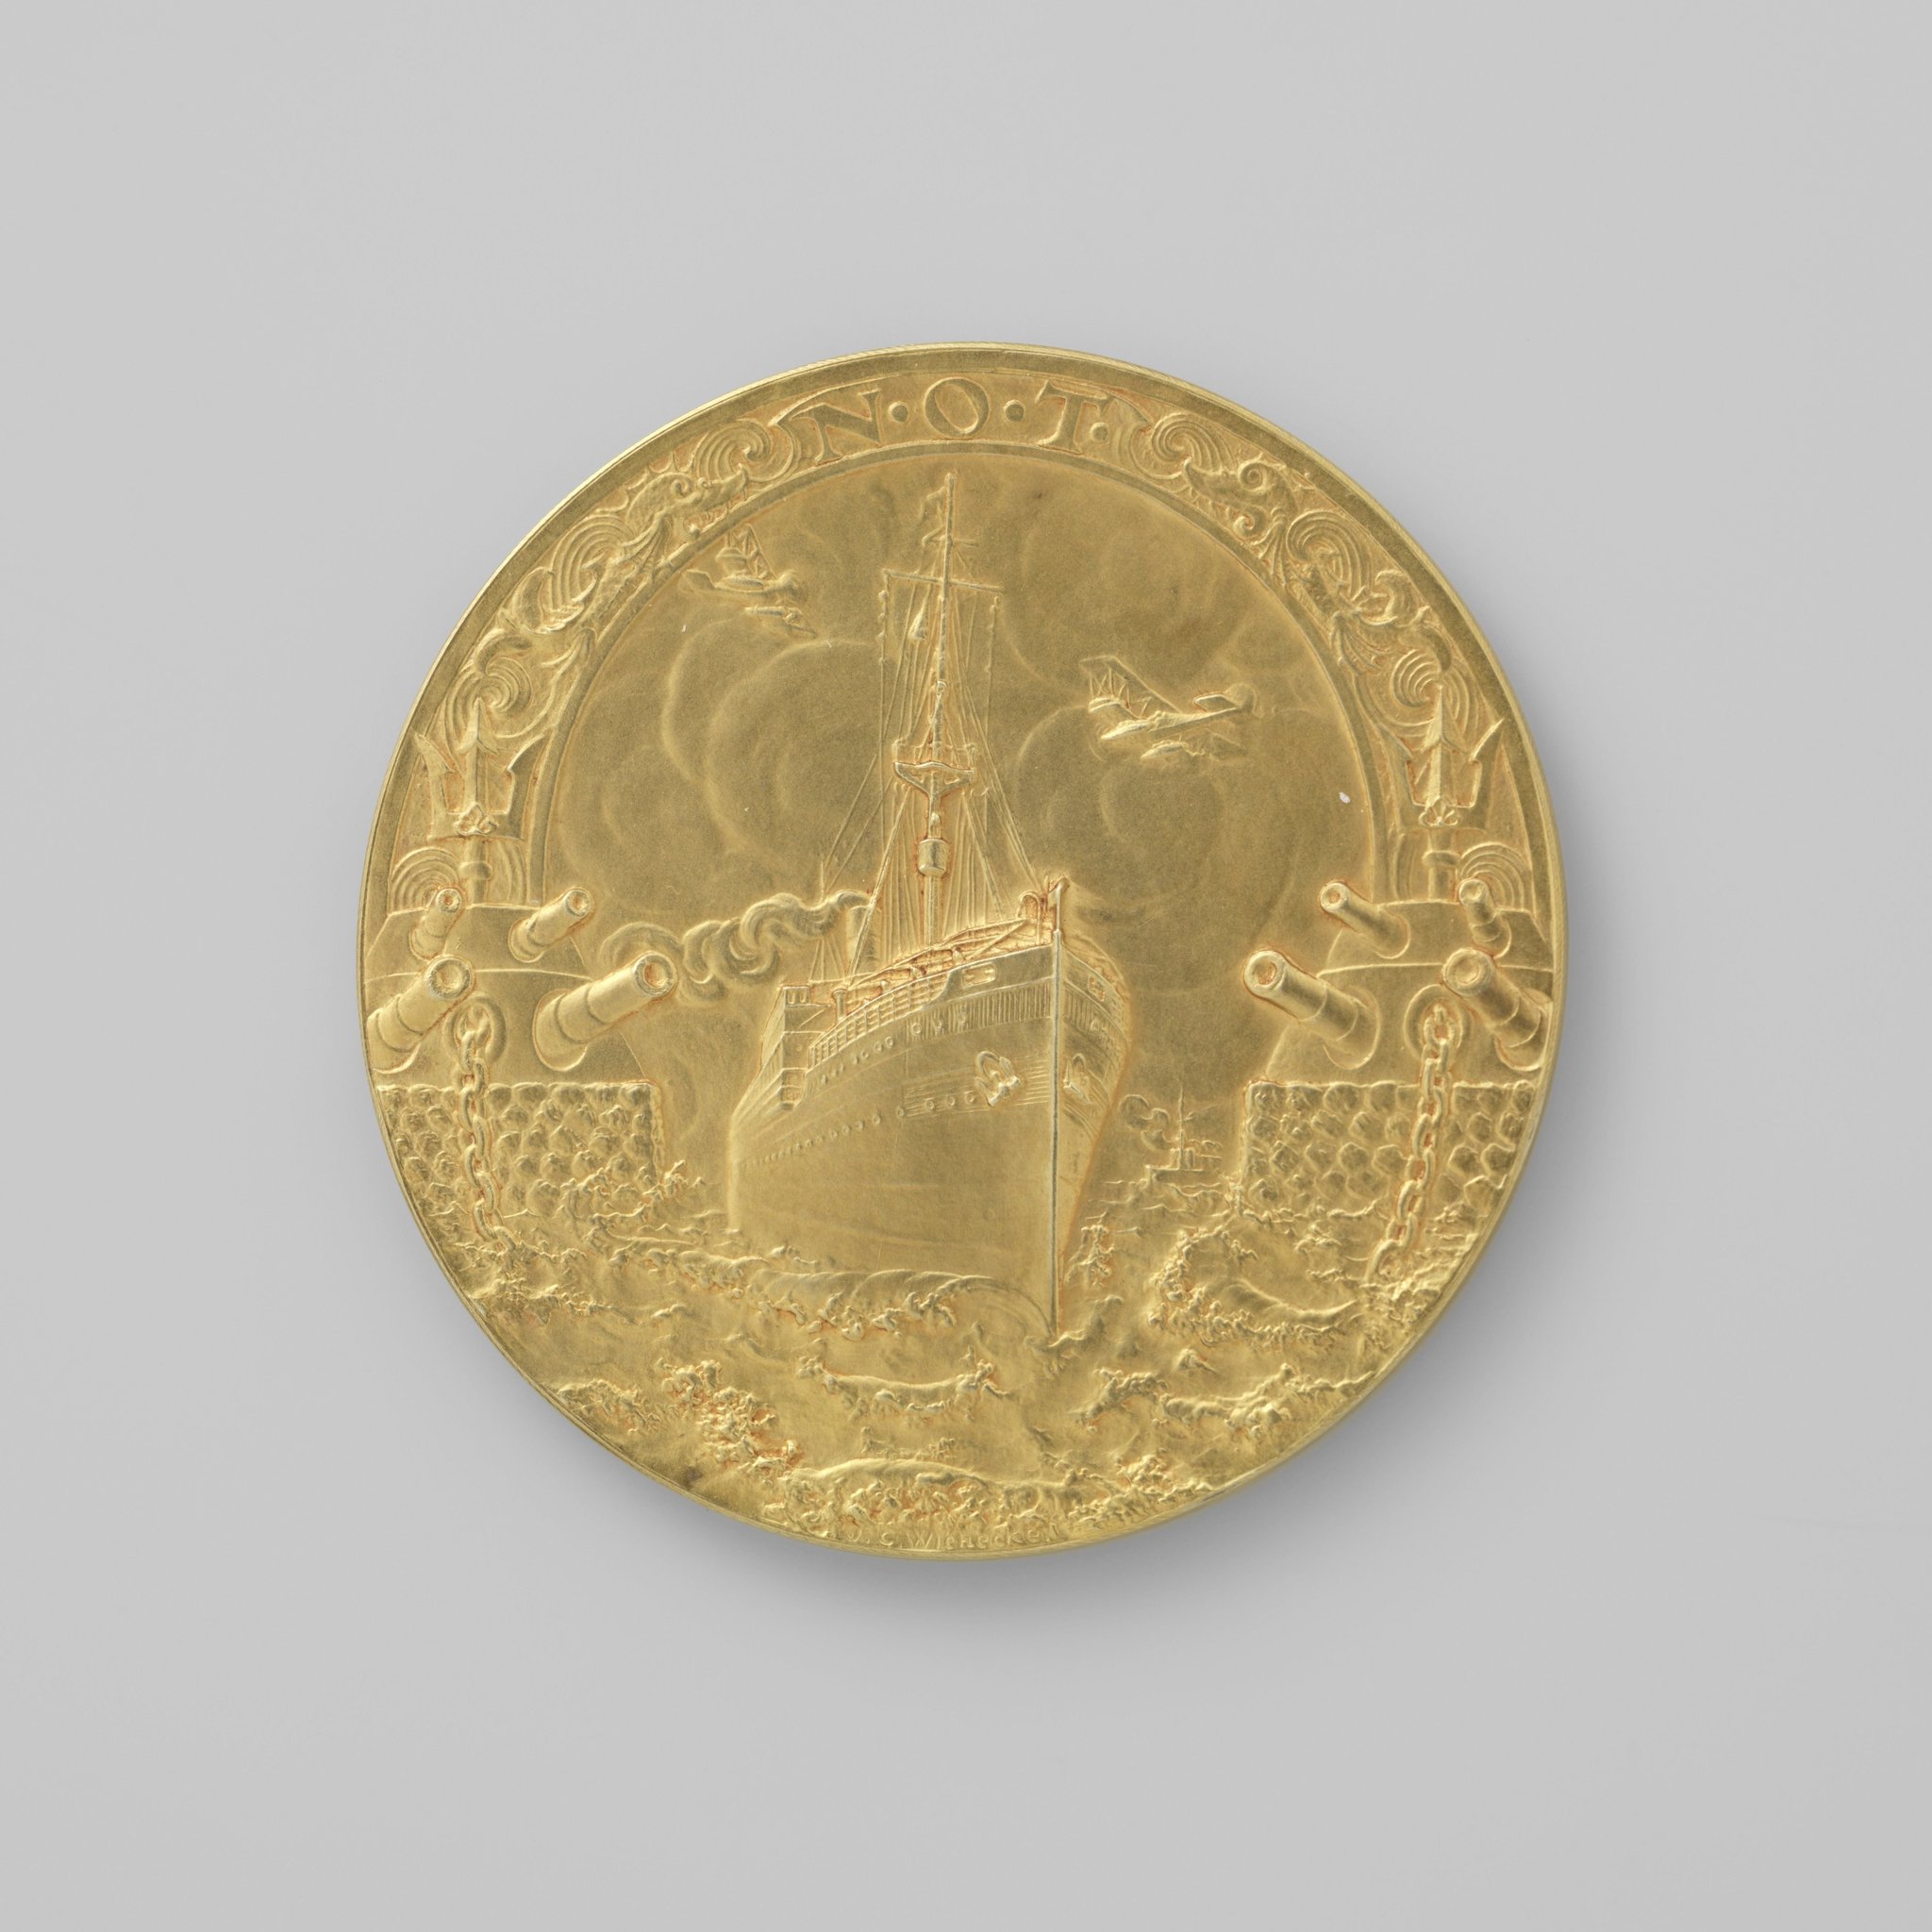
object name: honorary medal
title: Honorary Medal Awarded to C.J. van Aalst, Chairman of the Netherlands Overseas Trust Company, upon its Discontinuation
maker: johannes cornelis wienecke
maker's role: medailleur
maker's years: 1872-1945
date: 1919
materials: gold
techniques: striking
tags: not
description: People who have performed a heroic deed or reached the end of a long career are sometimes awarded a medal as a token of esteem and gratitude. Often these are made of gold. Especially in the seventeenth century, gold medals with their chains were literally a reward. They were subsequently melted down and converted into money, which is why so few have survived.